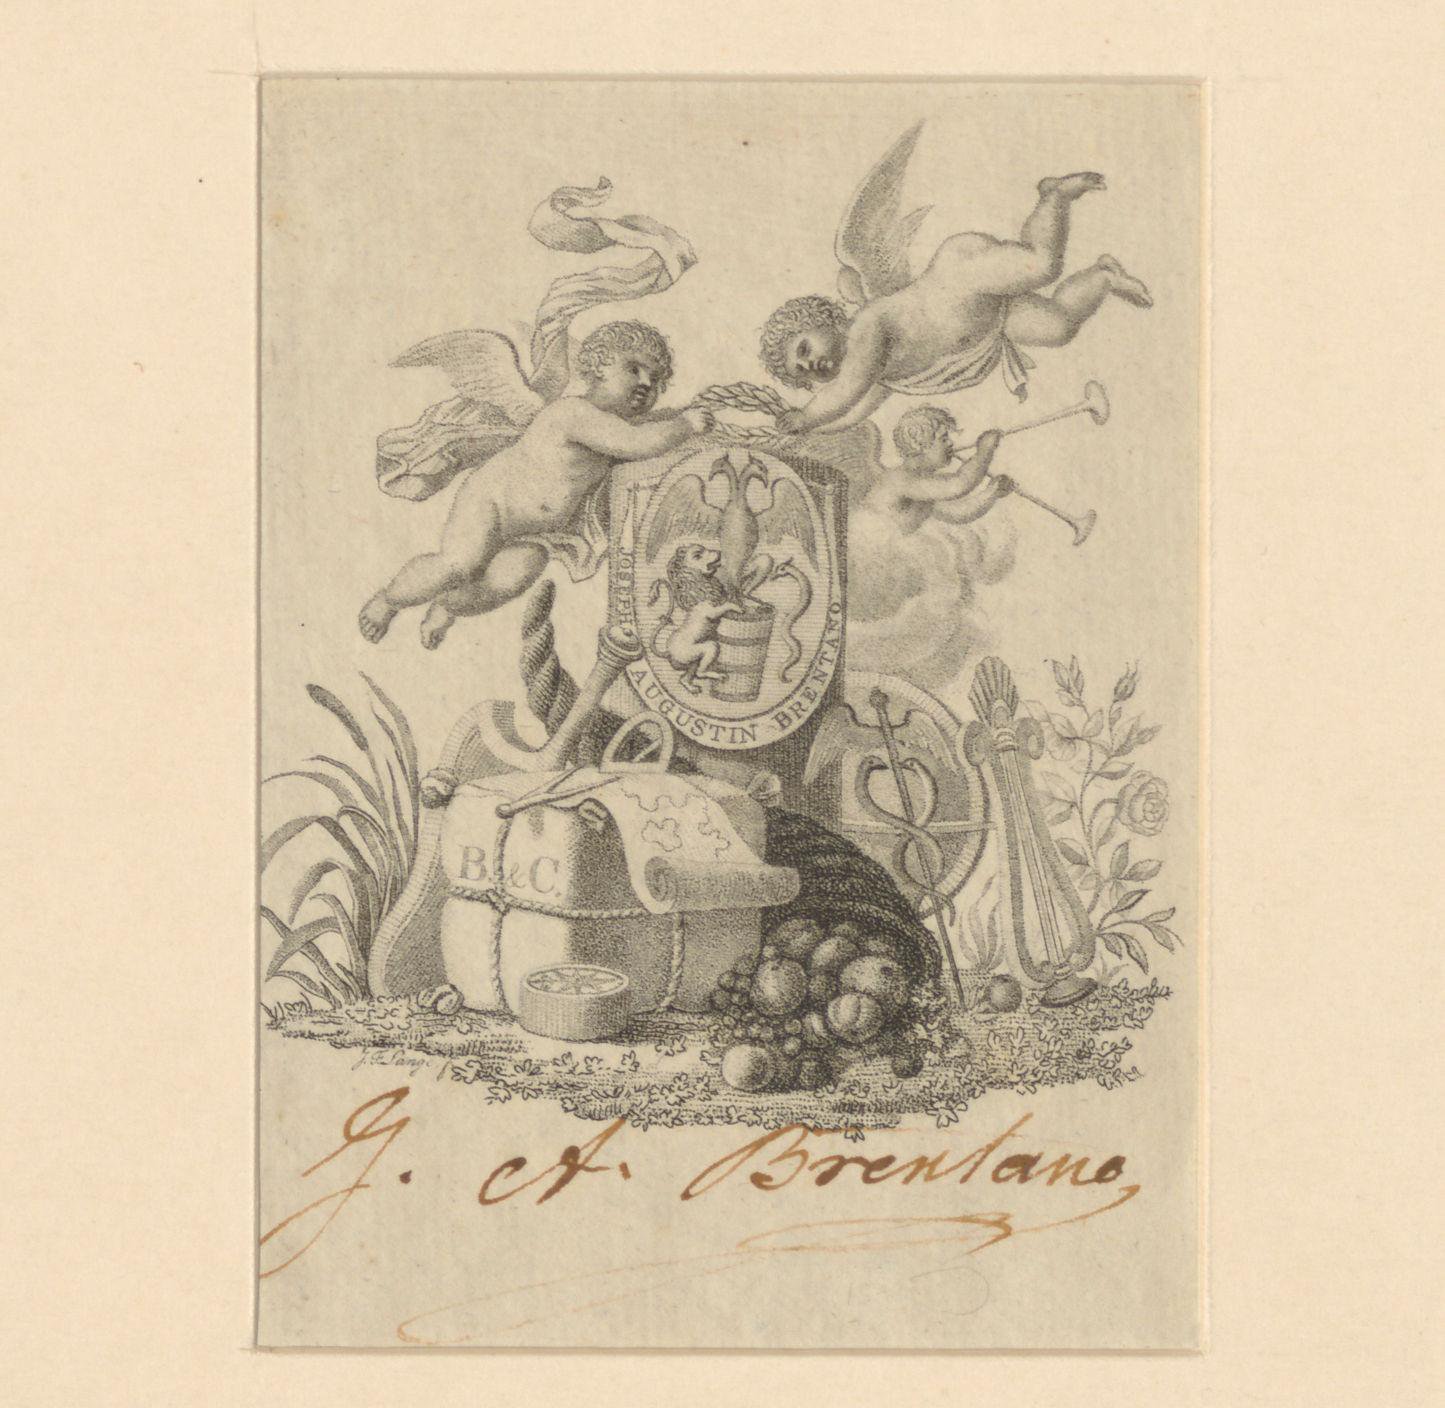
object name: print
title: Wapen van Josephus Augustinus Brentano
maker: Anonymous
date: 1800-1825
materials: paper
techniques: etching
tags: amsterdam, cupids: 'amores', 'amoretti', 'putti', armorial bearing, heraldry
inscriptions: inscription: ‘J. A. Brentano’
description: Bijgevoegd op het opzetvel is de eerste pagina van: Catalogus van het beroemde kabinet van schilderijen (...) nagelaten door den wel-edelen heer Josephus Augustinus Brentano (...). S.l.s.n., 1822, en een blad met handgeschreven tekst over de schilderijencollectie van Brentano, overgenomen uit: Eynden, Roeland van, en Adriaan van der Willigen. Geschiedenis der vaderlandsche schilderkunst, sedert de helft der XVIII eeuw. Amsterdam: C. Weddepohl, 1843, dl. 3.